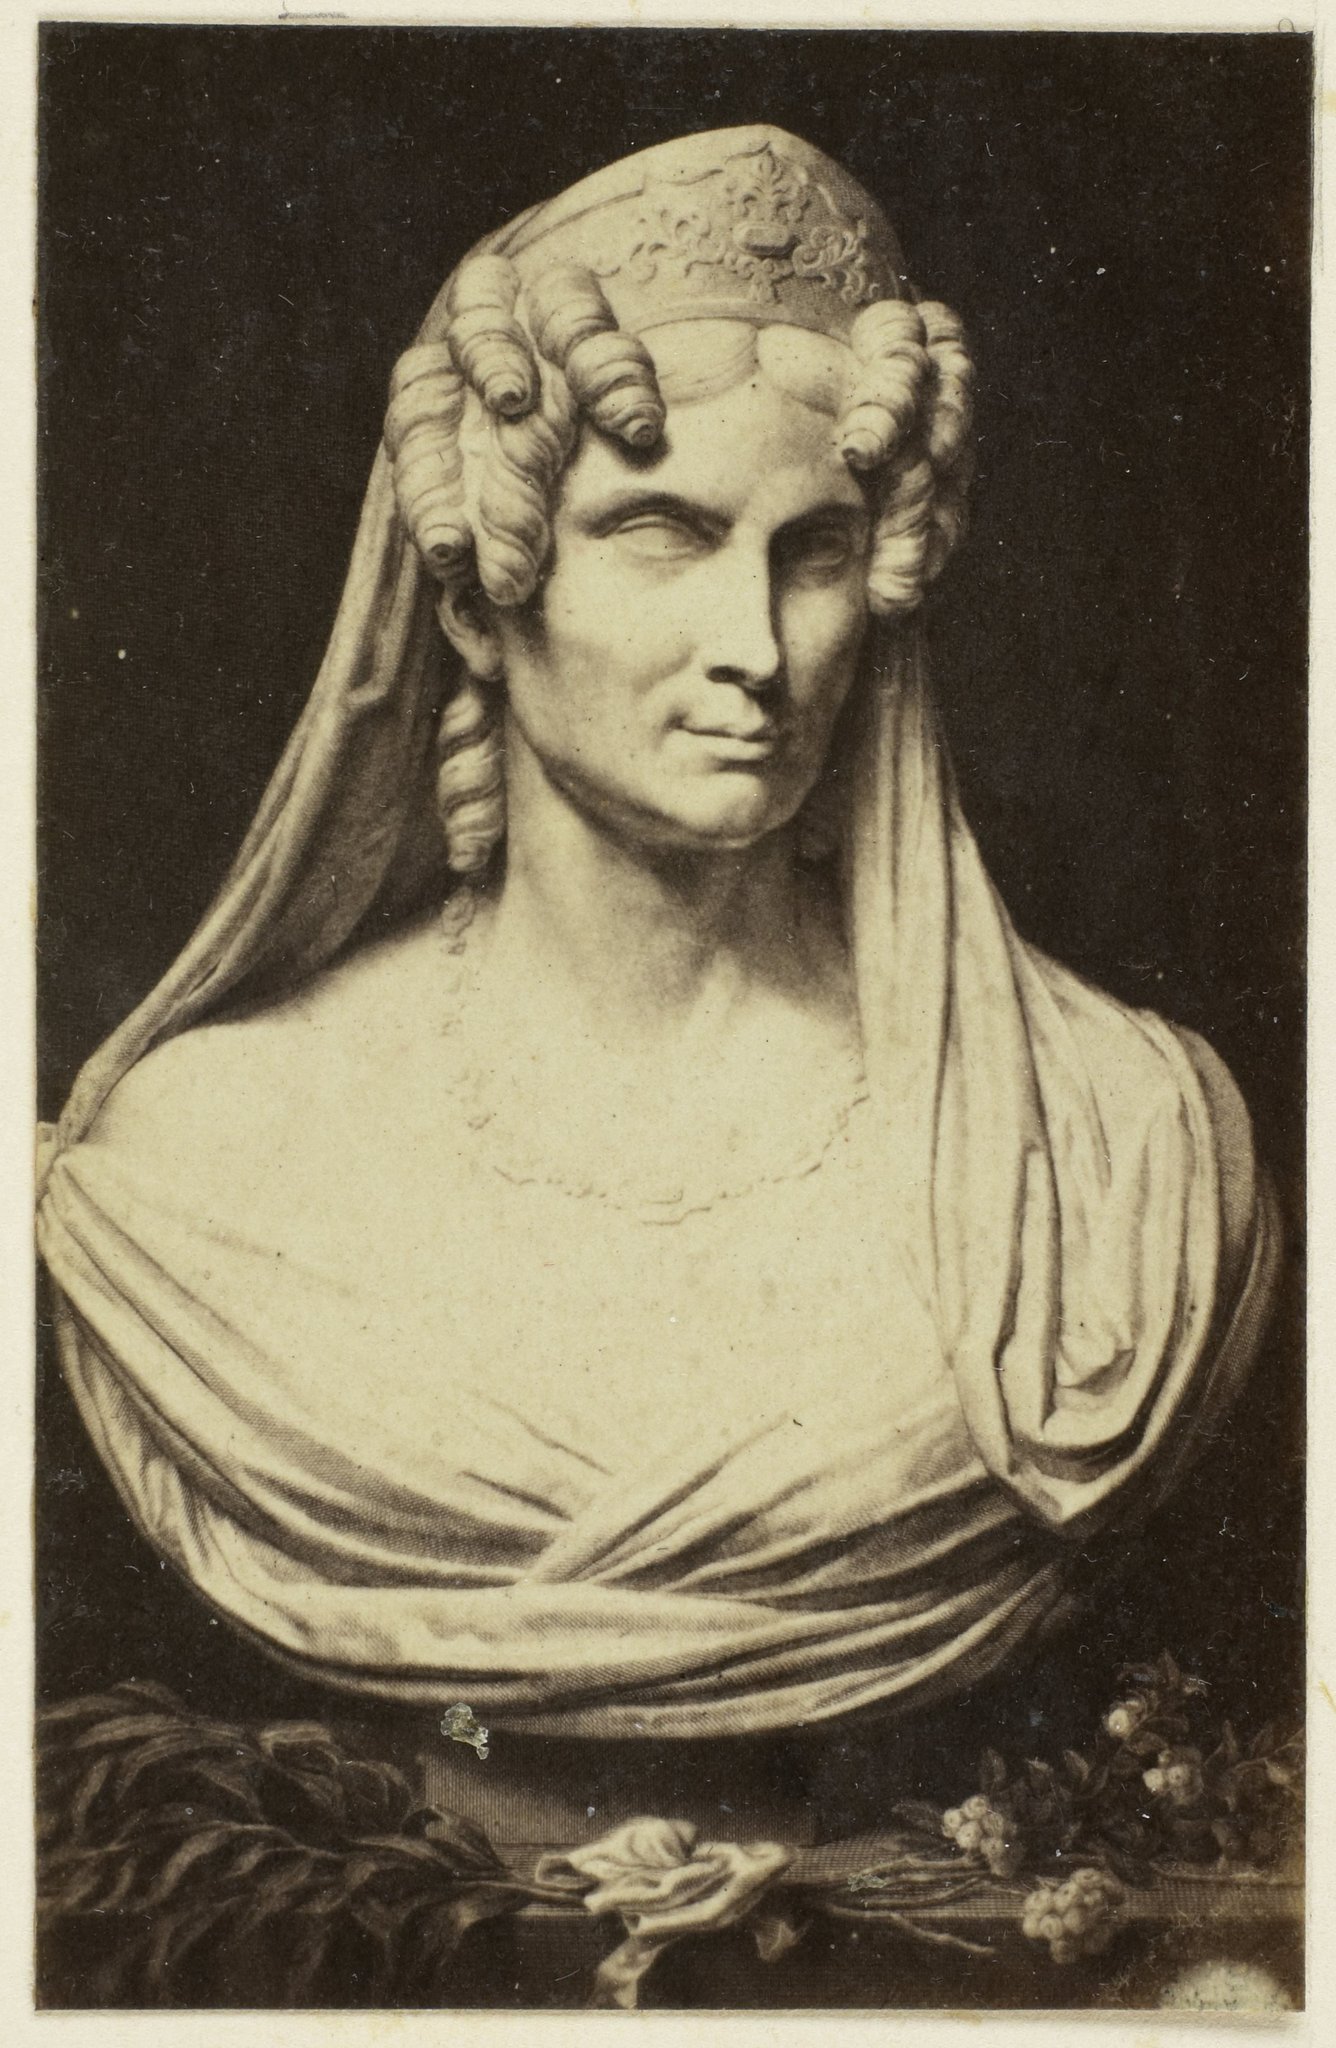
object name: photograph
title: Buste van koningin Wilhelmina van Pruisen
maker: eduard isaac asser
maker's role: amateurfotograaf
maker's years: 1809-1894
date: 1855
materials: cardboard, paper, photographic support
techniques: salted paper print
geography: amsterdam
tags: berlin, the hague, wilhelmina frederica louisa (koningin der nederlanden)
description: Foto-reproductie van een prent van Louis Royers